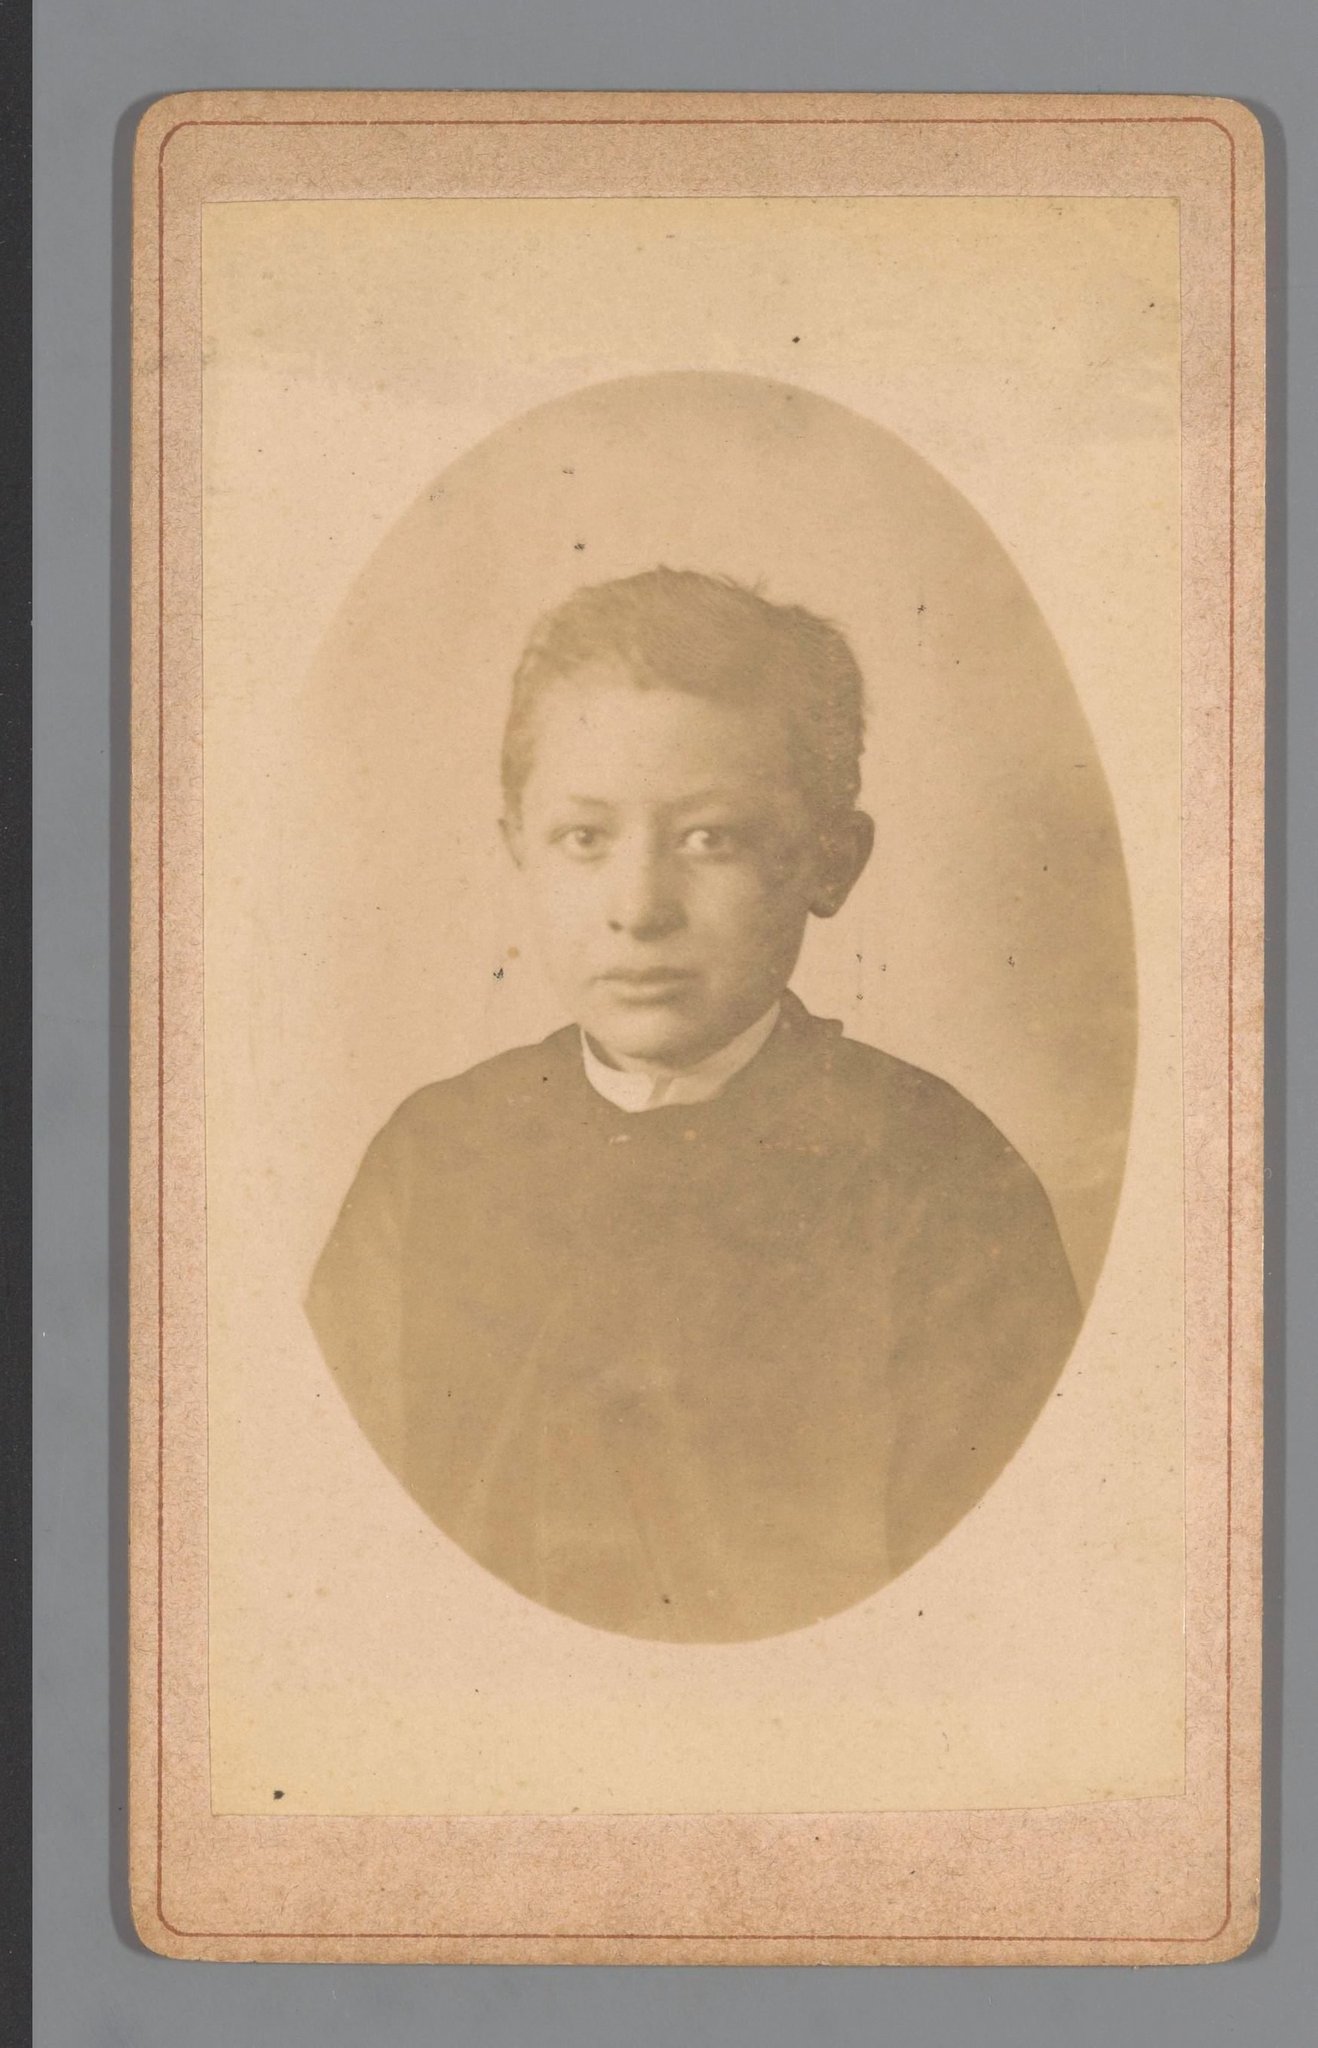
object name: carte de visite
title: Portret van een onbekende jongen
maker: Anonymous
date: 1860-1900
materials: cardboard, paper, photographic support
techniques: albumen print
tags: boy (child between toddler and youth)